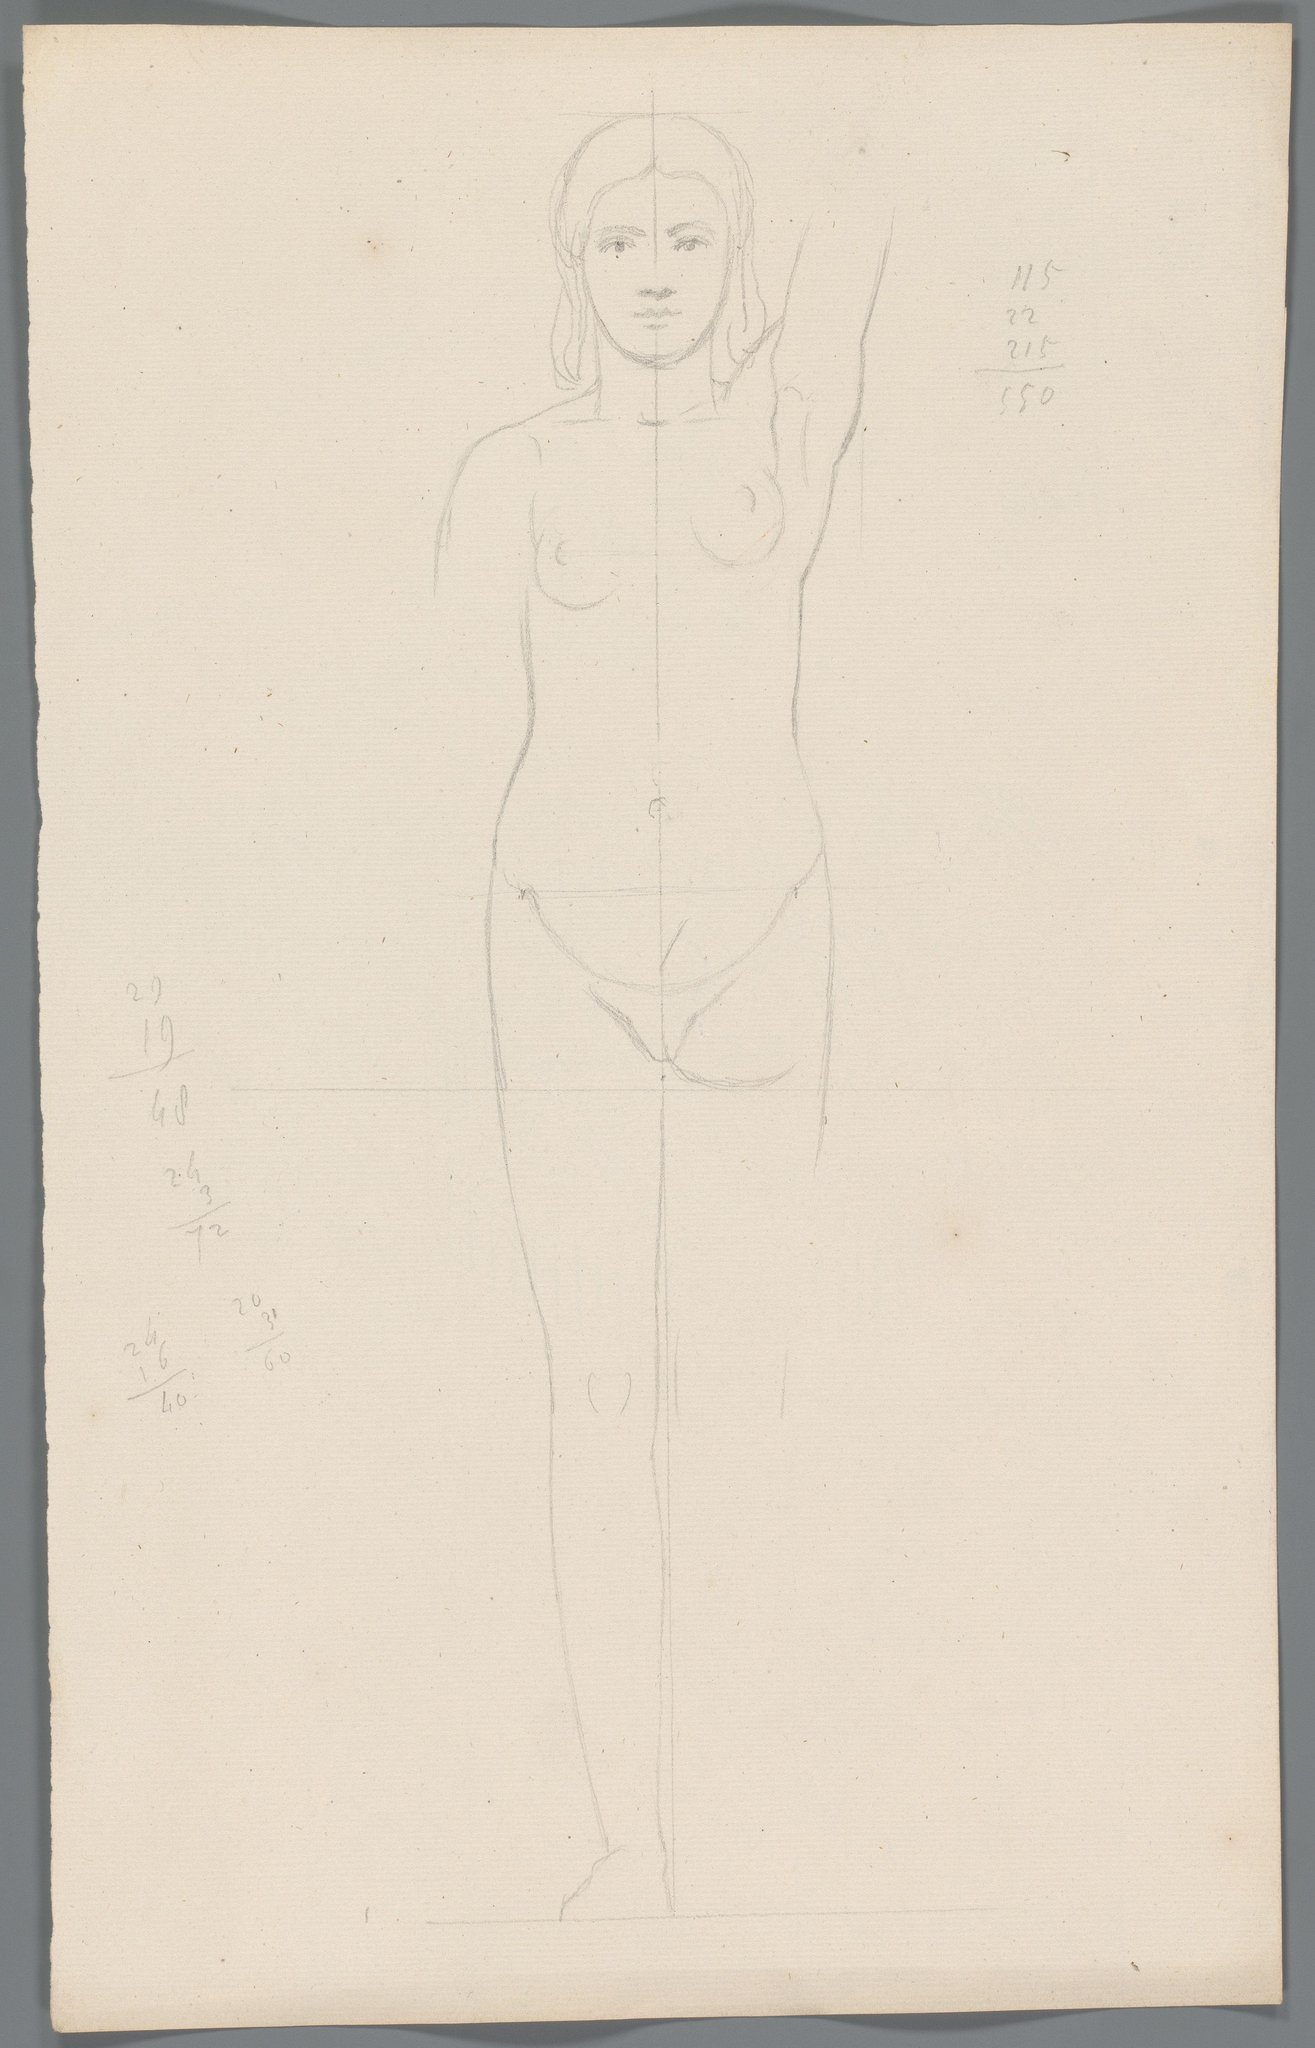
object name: drawing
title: Studie van een jonge vrouw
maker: jacobus everhardus josephus van den berg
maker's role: draughtsman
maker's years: 1802-1861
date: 1812-1861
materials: paper, pencil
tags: adolescent, young woman, maiden, standing figure (canon, proportions) - aa - female human figure, anatomy (non-medical) - aa - female human figure